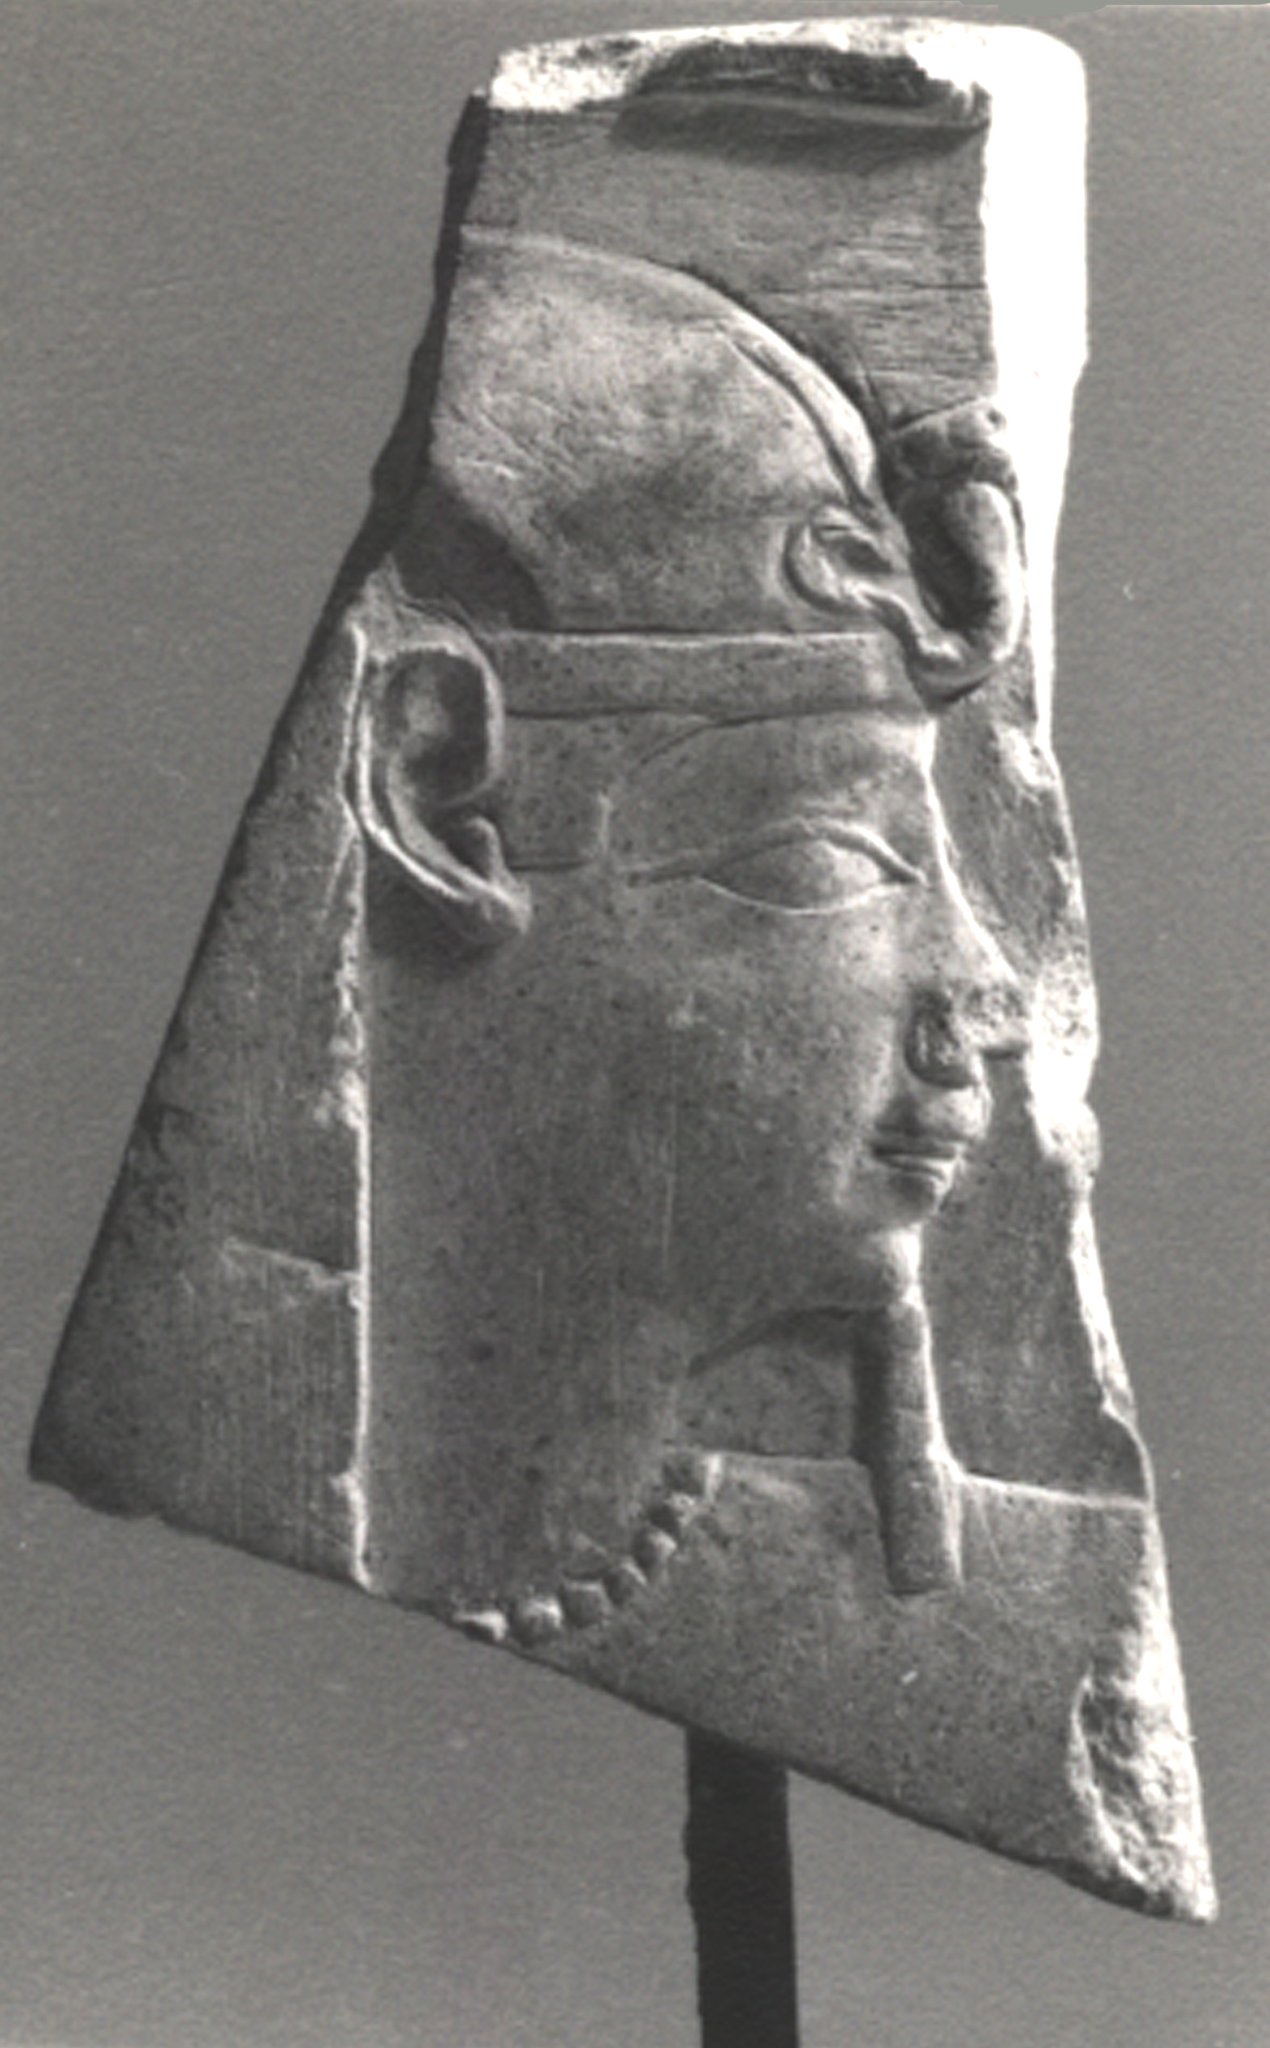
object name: sculptor's model votive, relief, head, king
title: Plaque with a Relief Head of a King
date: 522-30 BCE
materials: limestone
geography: egypt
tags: kings,heads